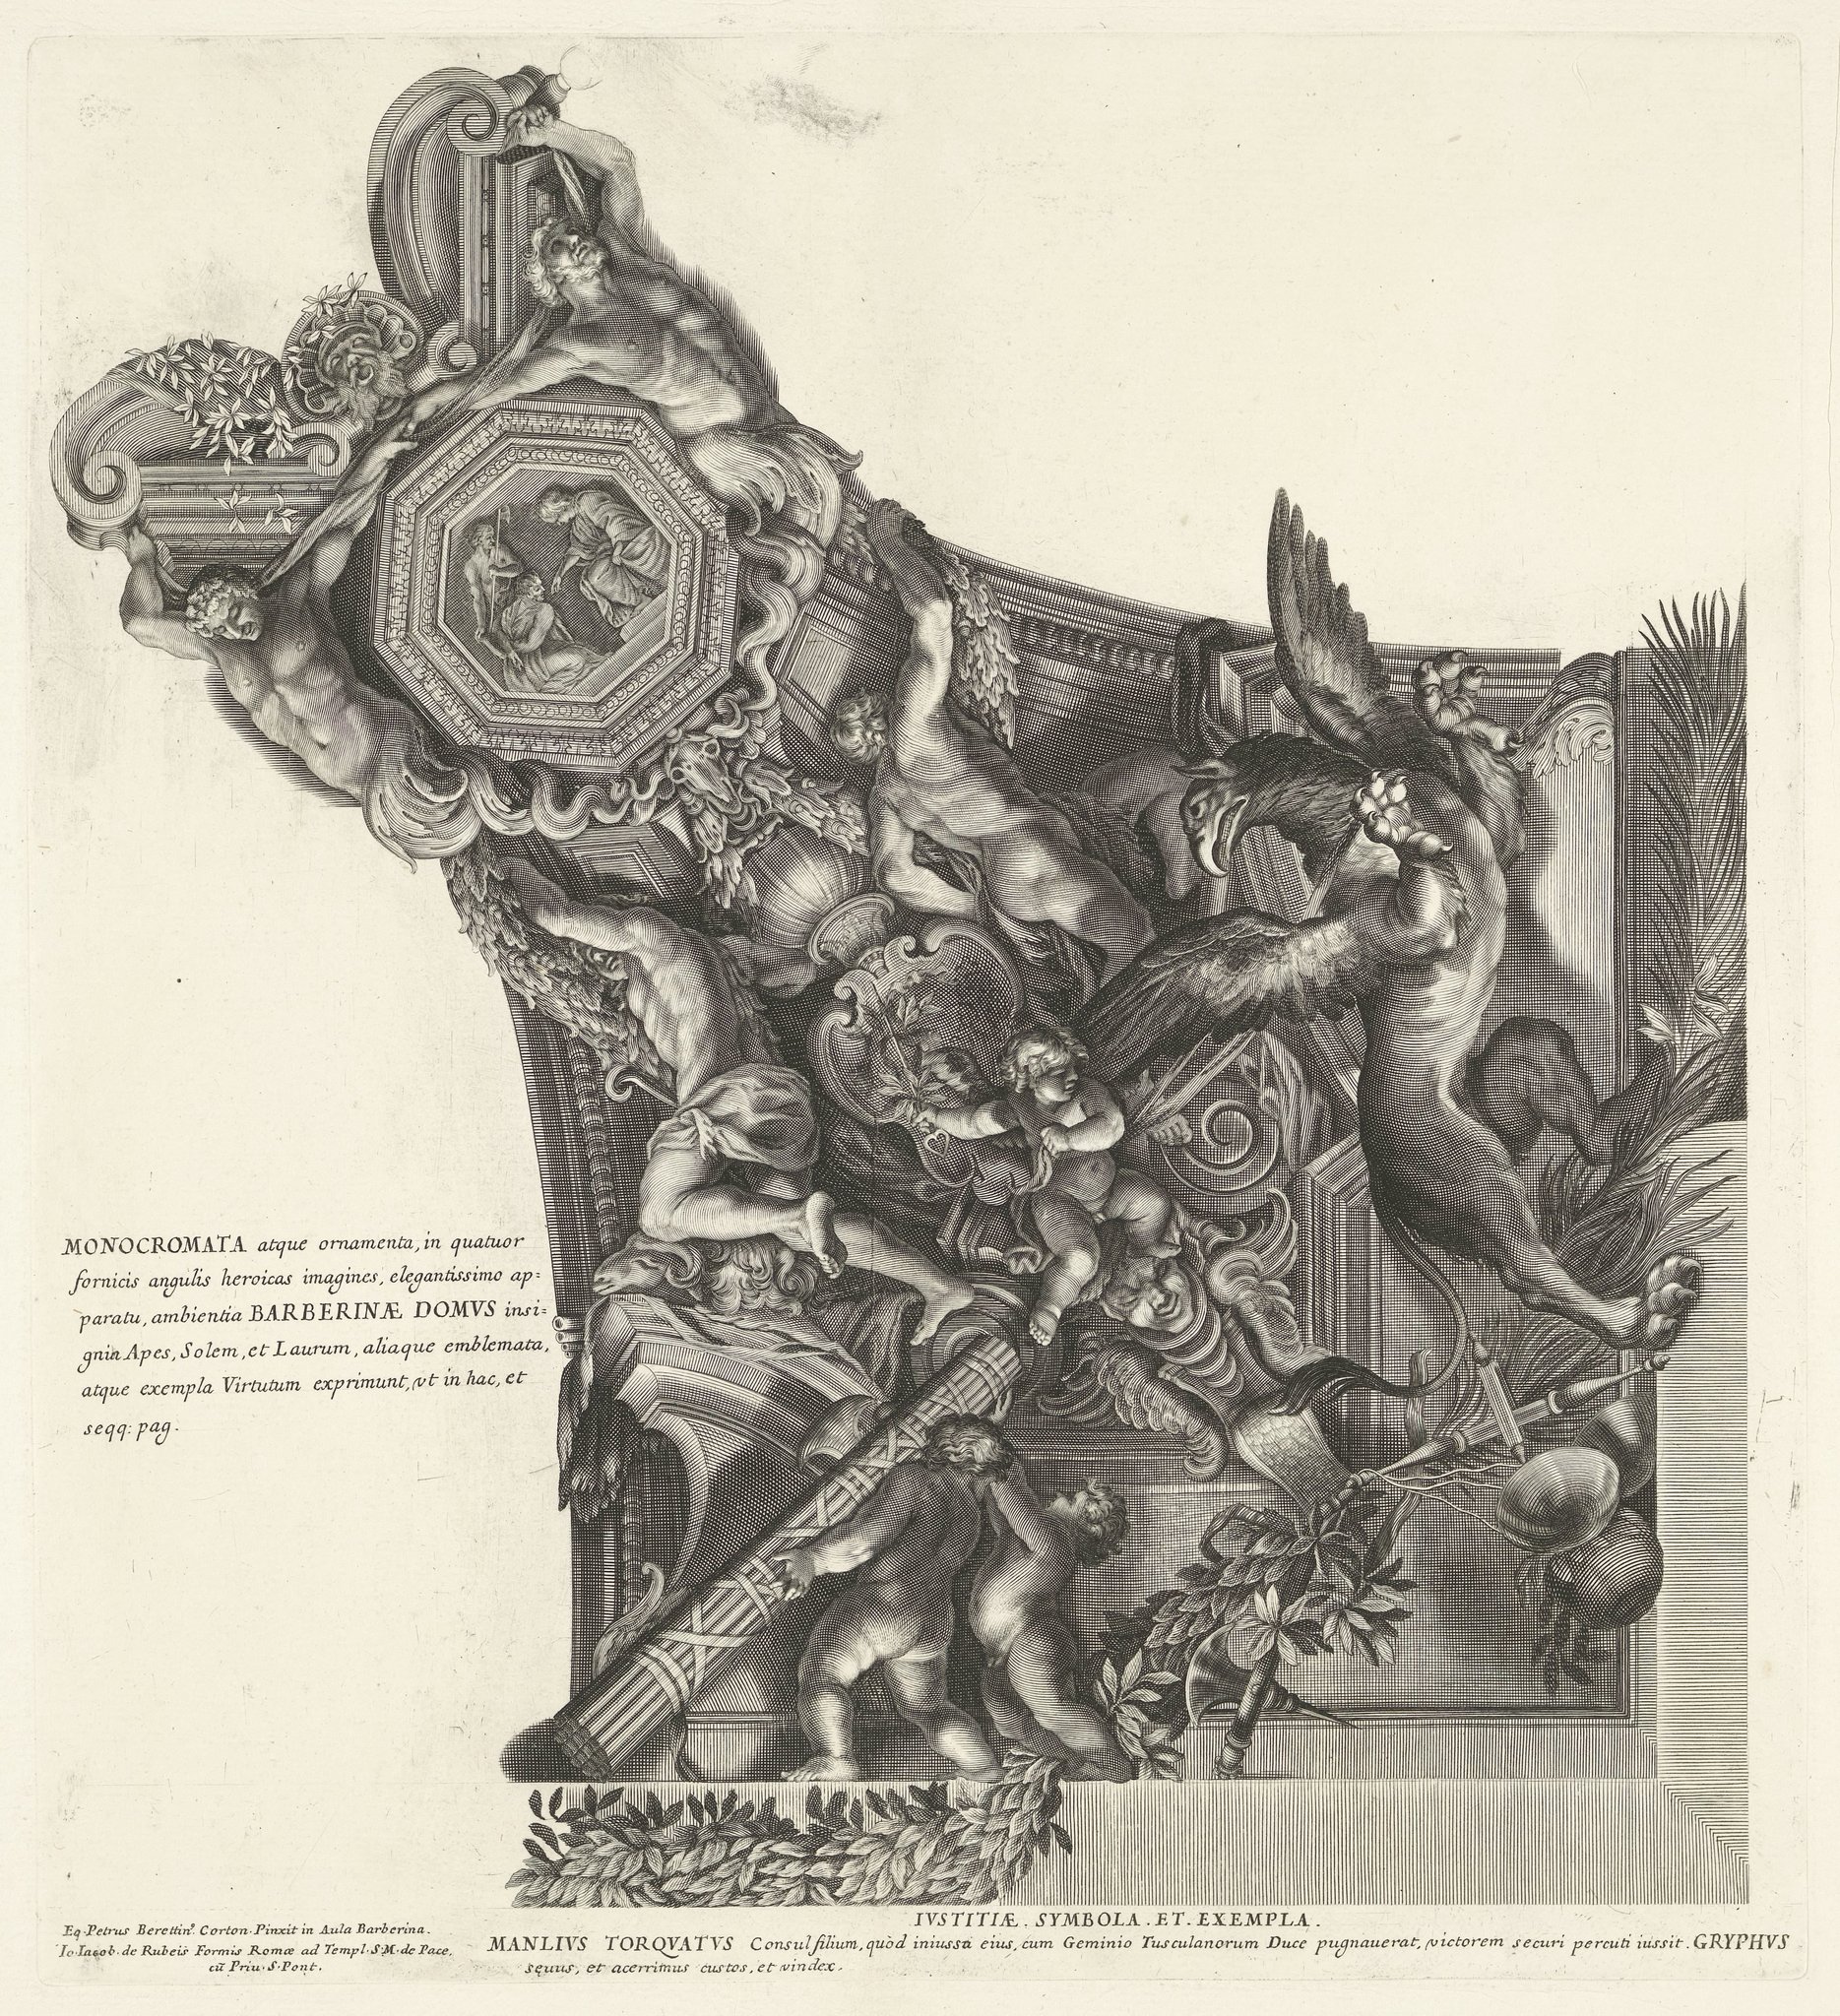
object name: print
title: Barberinae Aulae Fornix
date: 1692-1762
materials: paper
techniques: engraving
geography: vatican city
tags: griffin (lion/eagle); 'griffo' (ripa), justice, 'justitia'; 'giustitia divina' (ripa) ~ one of the four cardinal virtues, cupids: 'amores', 'amoretti', 'putti'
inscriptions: collector's mark: Lugt 240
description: Deel van de gewelfdecoratie in de salon van Palazzo Barberini met een allegorie op de Rechtvaardigheid (Justitia), met een griffioen, putti en een medaillon met een voorstelling van Manlius Torquatus.